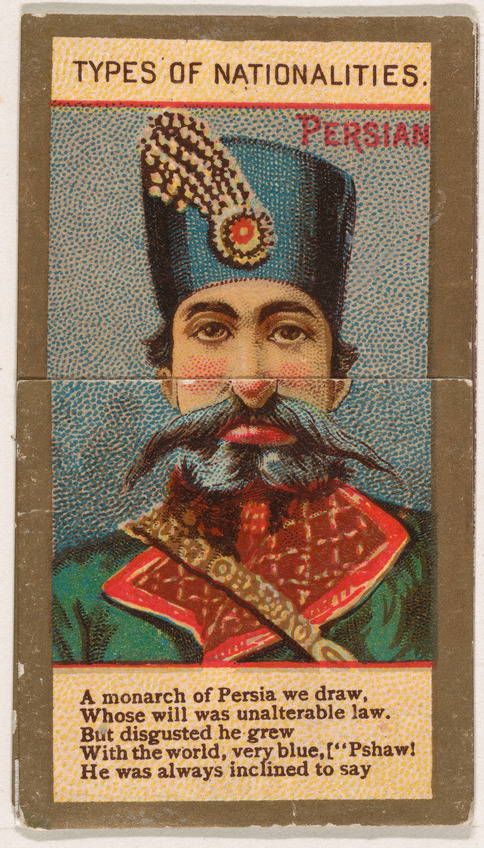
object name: print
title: Persian, from Types of Nationalities (N240) issued by Kinney Bros.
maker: kinney brothers tobacco company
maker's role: publisher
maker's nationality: american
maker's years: 1869-2011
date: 1890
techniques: color lithograph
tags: men